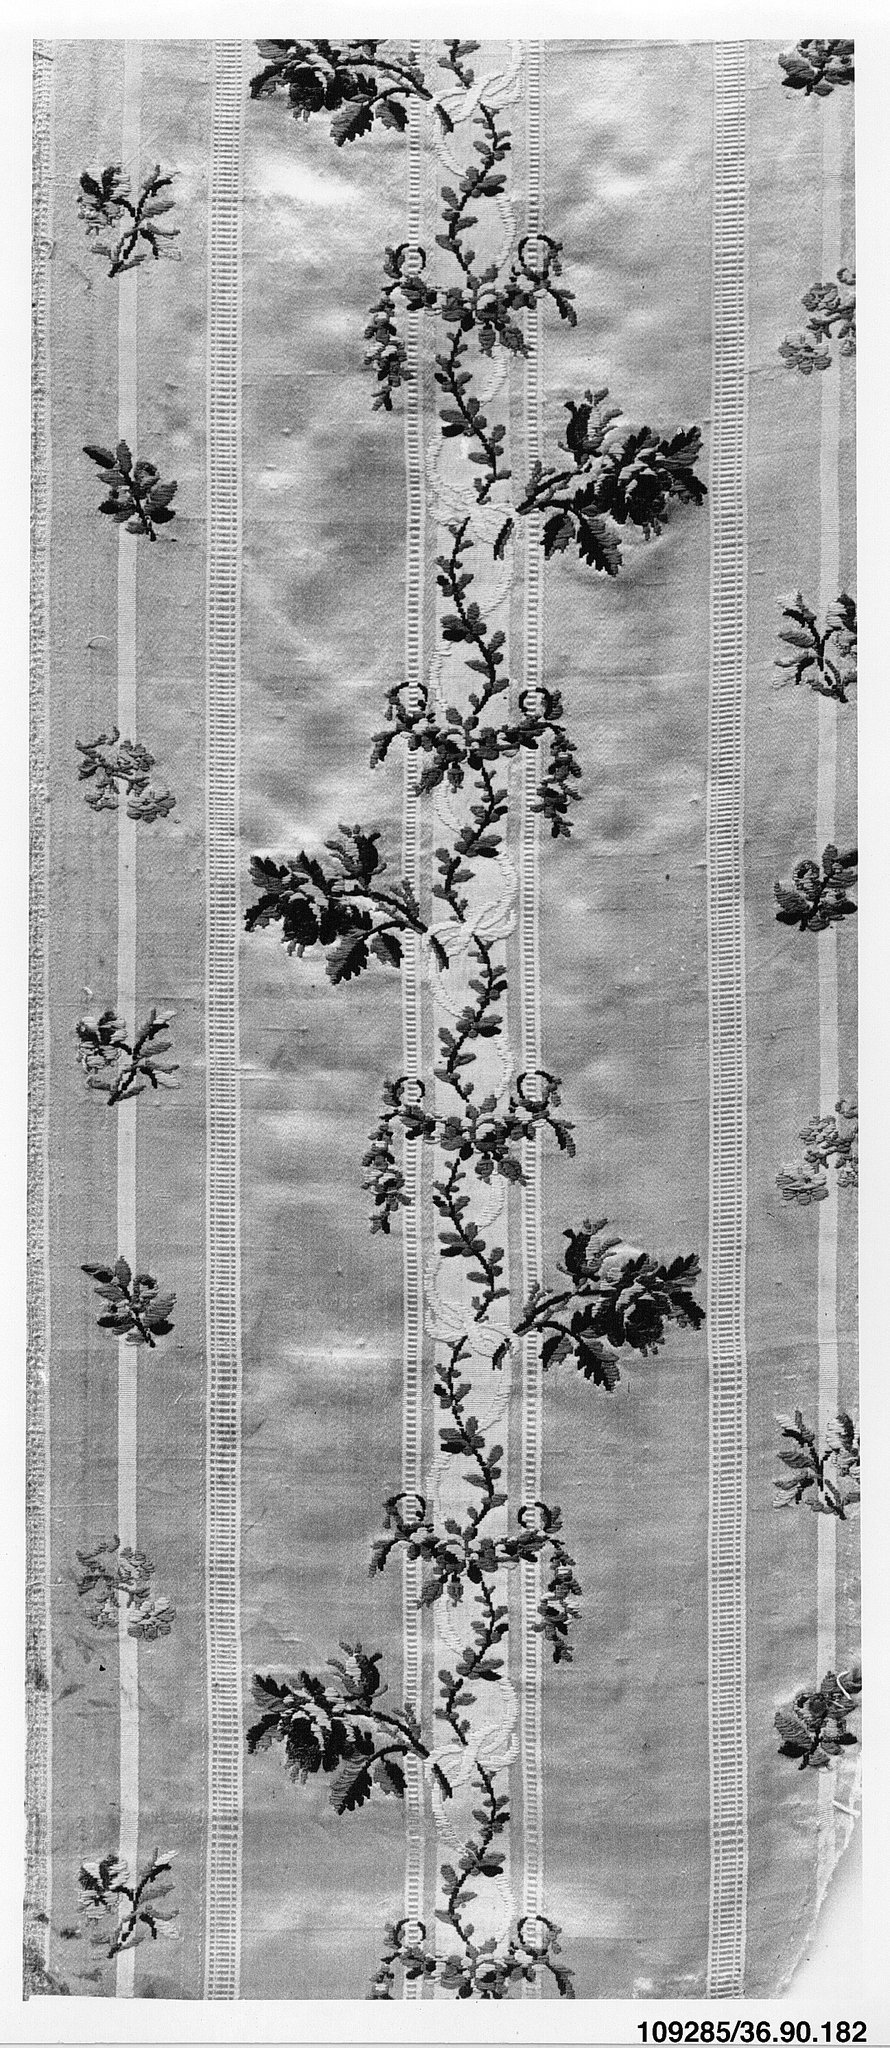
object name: piece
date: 1701-1800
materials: silk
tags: leaves